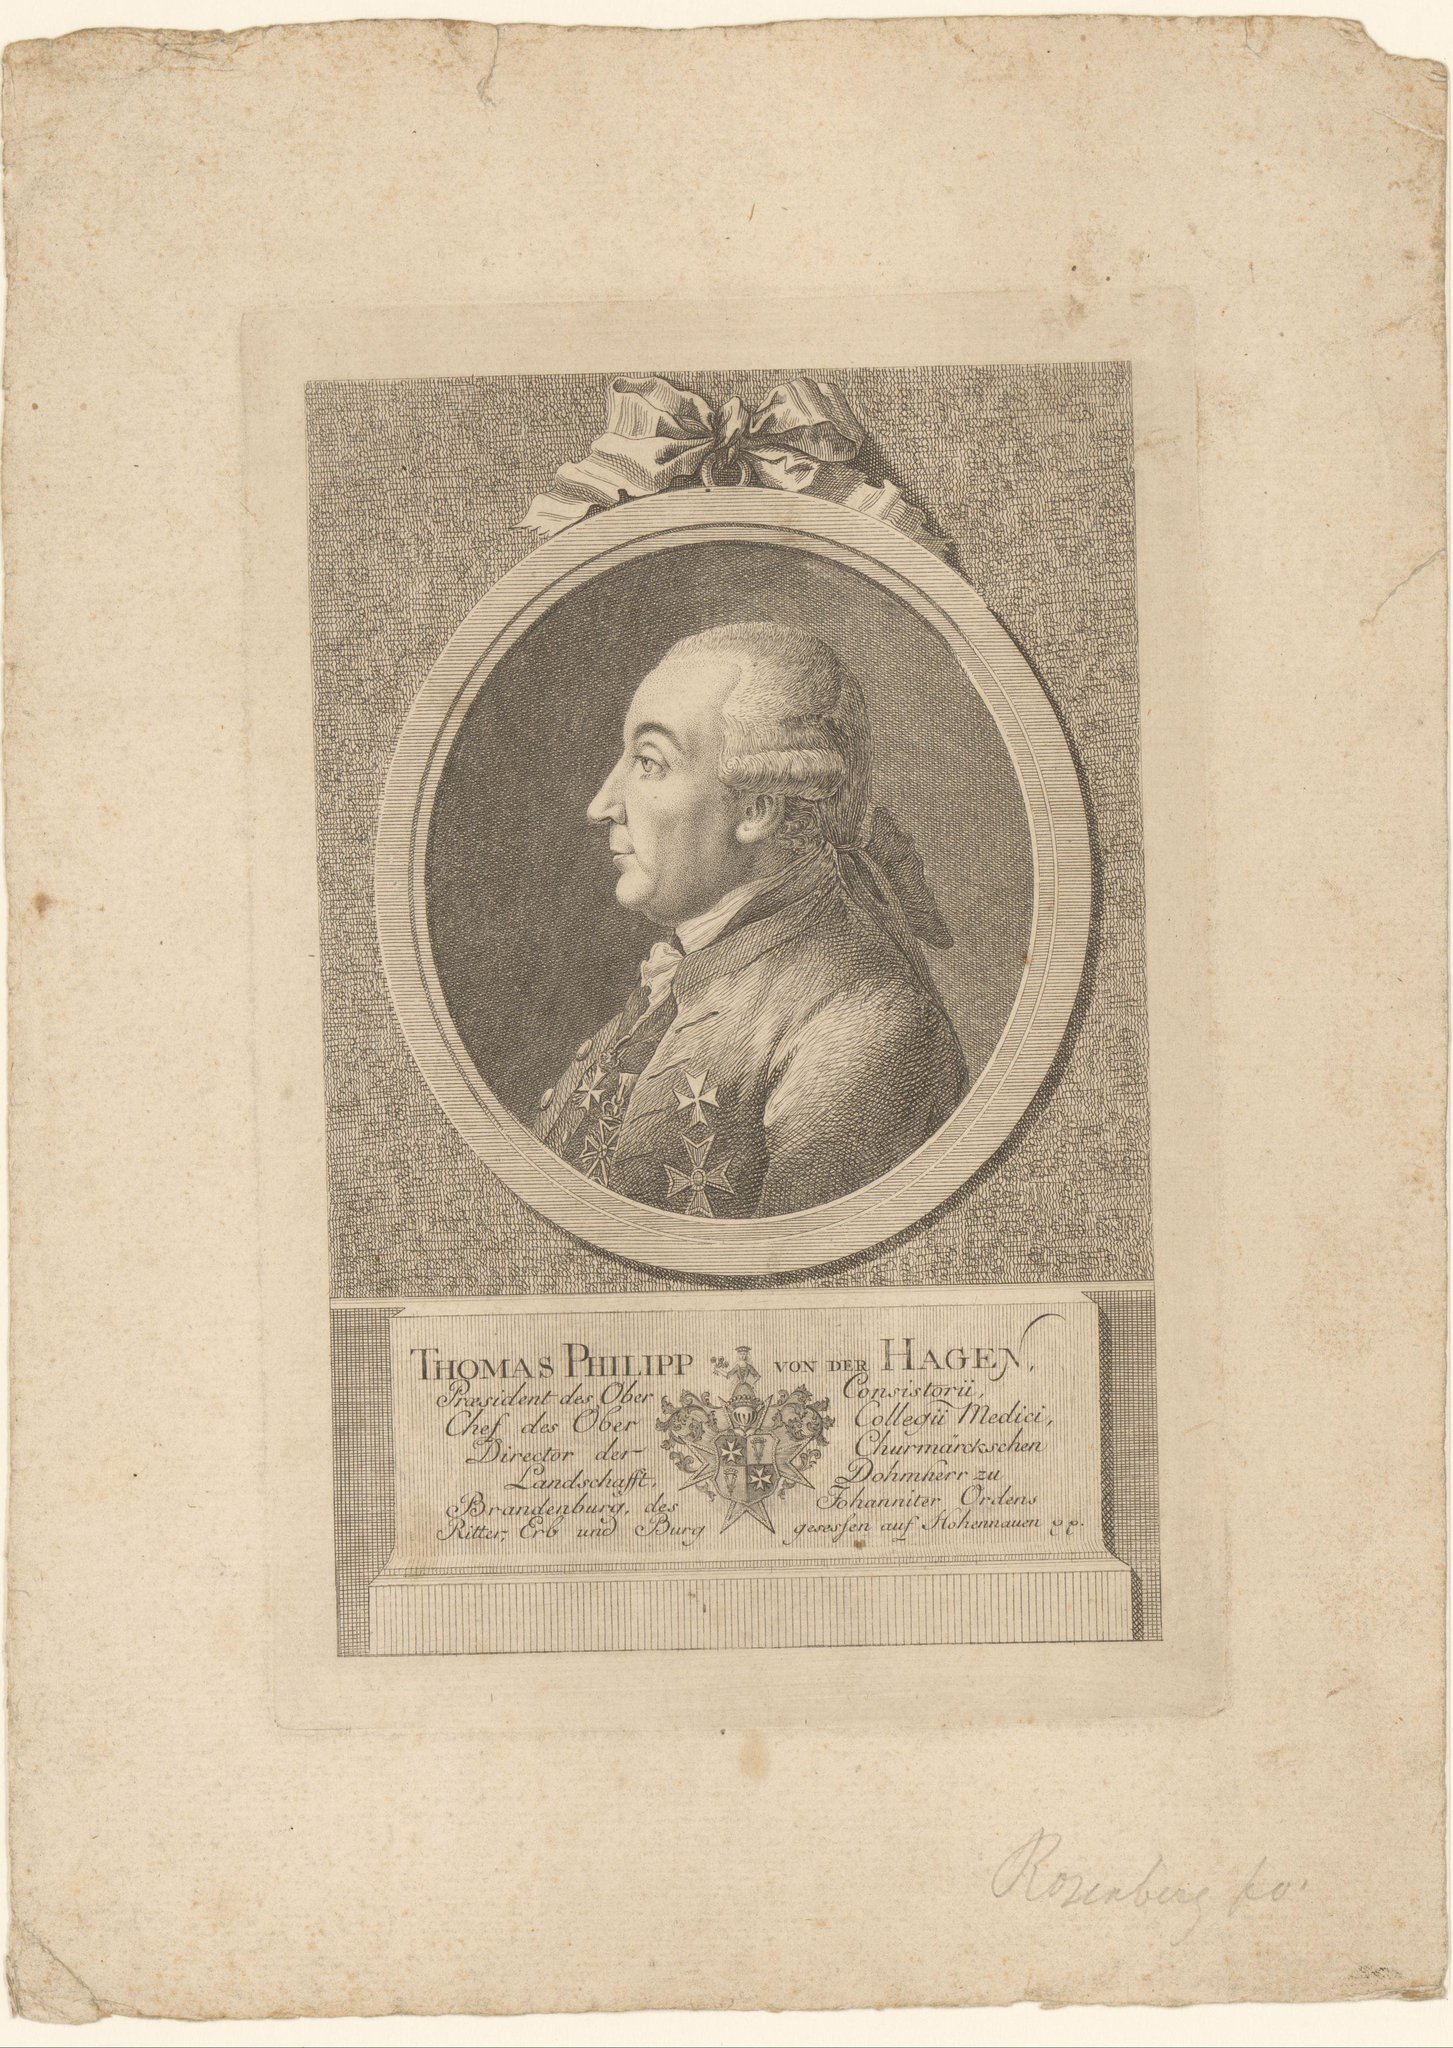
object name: print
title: Portret van Thomas Philipp von der Hagen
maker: johann georg rosenberg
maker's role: print maker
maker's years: 1739-1808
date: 1749-1808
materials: paper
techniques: etching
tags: berlin, historical persons, medals and other marks of military honour, armorial bearing, heraldry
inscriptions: collector's mark: Lugt 2228